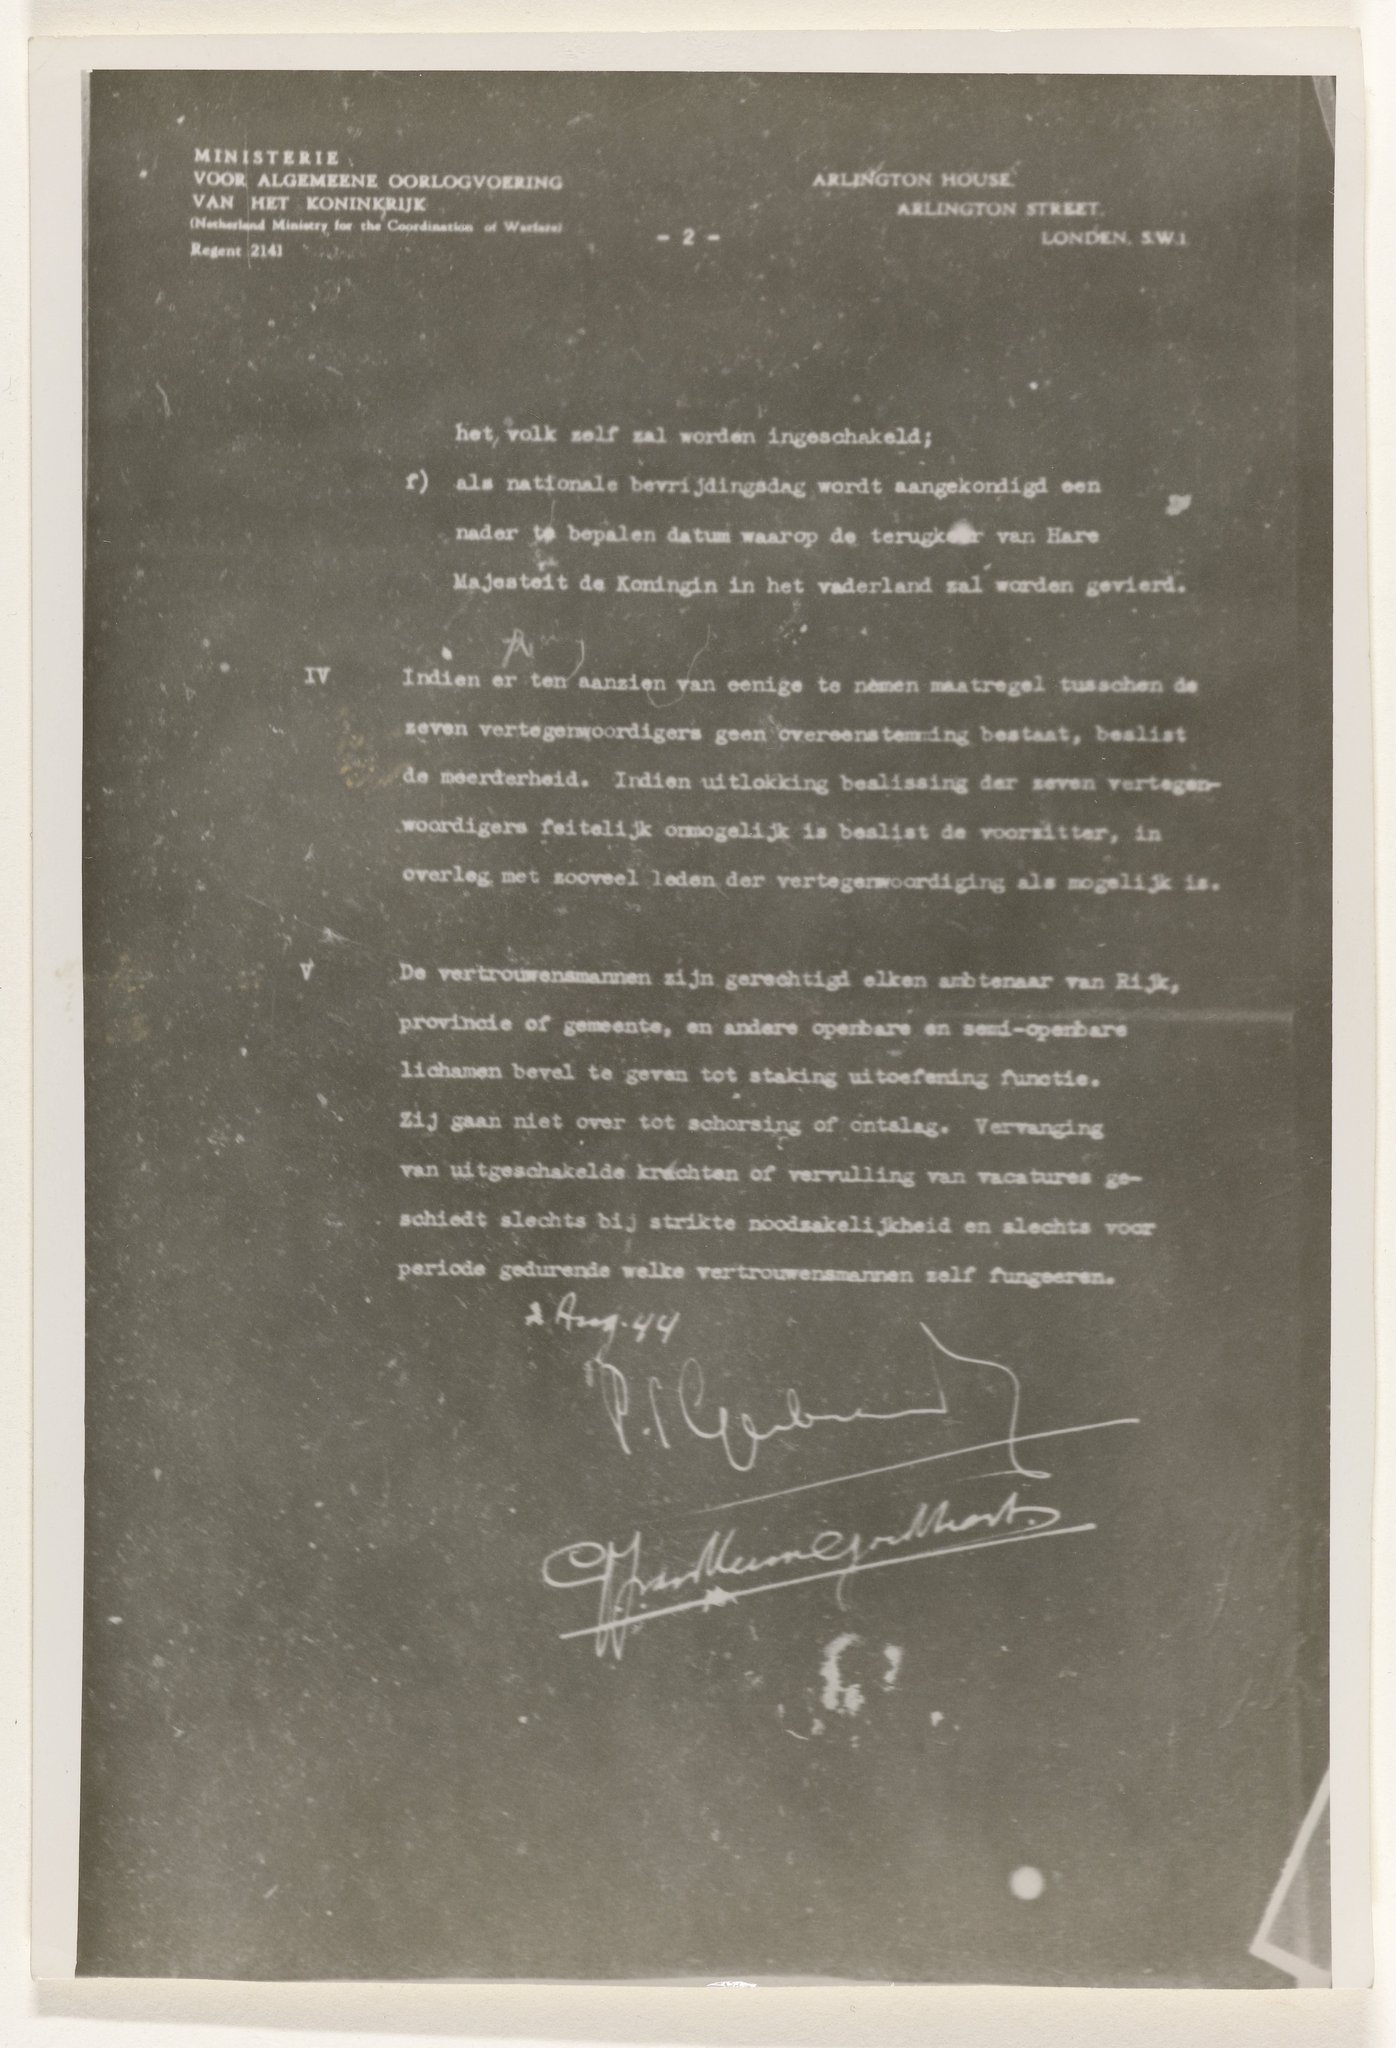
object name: photograph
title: Nederlandse regering in Londen in ballingschap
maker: pieter sjoerds gerbrandy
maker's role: minister van staat, tweede kamerlid, hoogleraar, lid tweede kamer, minister-president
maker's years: 1885-1961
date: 1944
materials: photographic support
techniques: photography, typewriting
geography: london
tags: the hague, pieter sjoerds gerbrandy, willem drees, netherlands, london